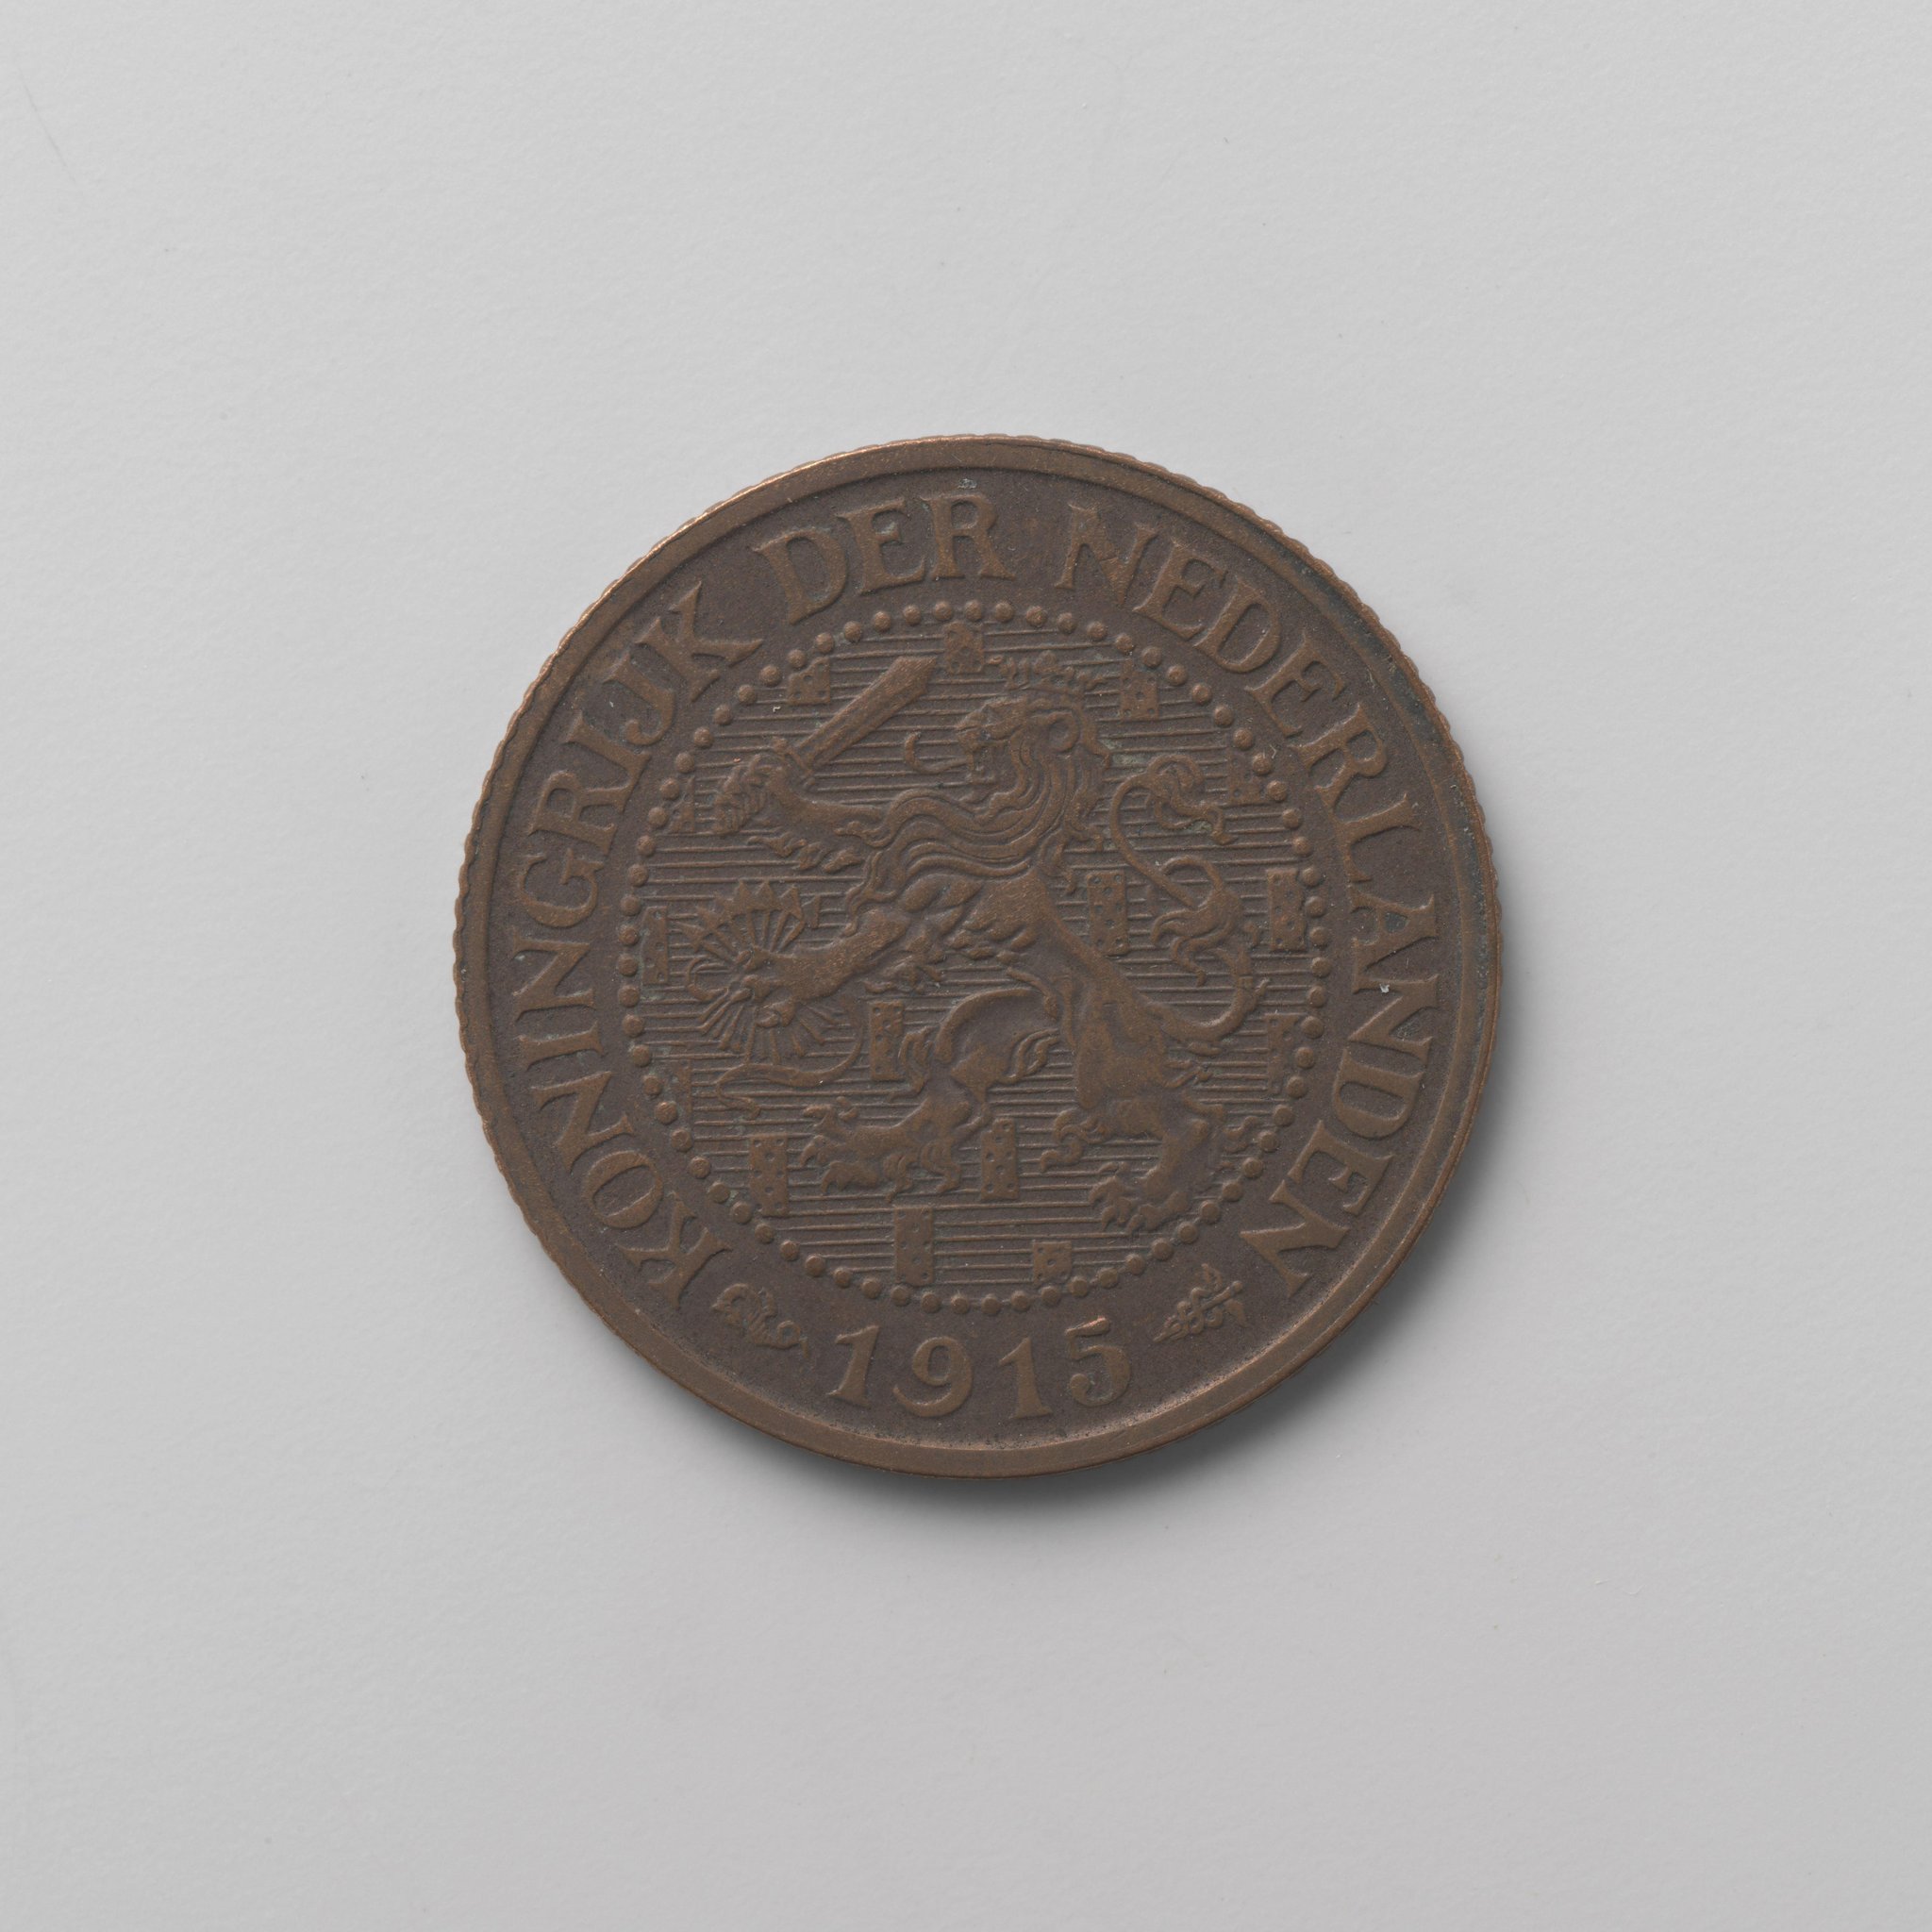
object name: twee en een halve cent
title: Nederland, 2½ cent,1915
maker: wilhelmina of the netherlands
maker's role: print maker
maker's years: 1880-1962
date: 1915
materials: bronze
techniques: striking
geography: utrecht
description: Bronzen munt. Voorzijde: in een veld rijkswapen. Jaartal onderaan in omschrift.Keerzijde: binnen twee samengebonden oranjetakken waarde-aanduiding 2½ cent. Kartelrand.